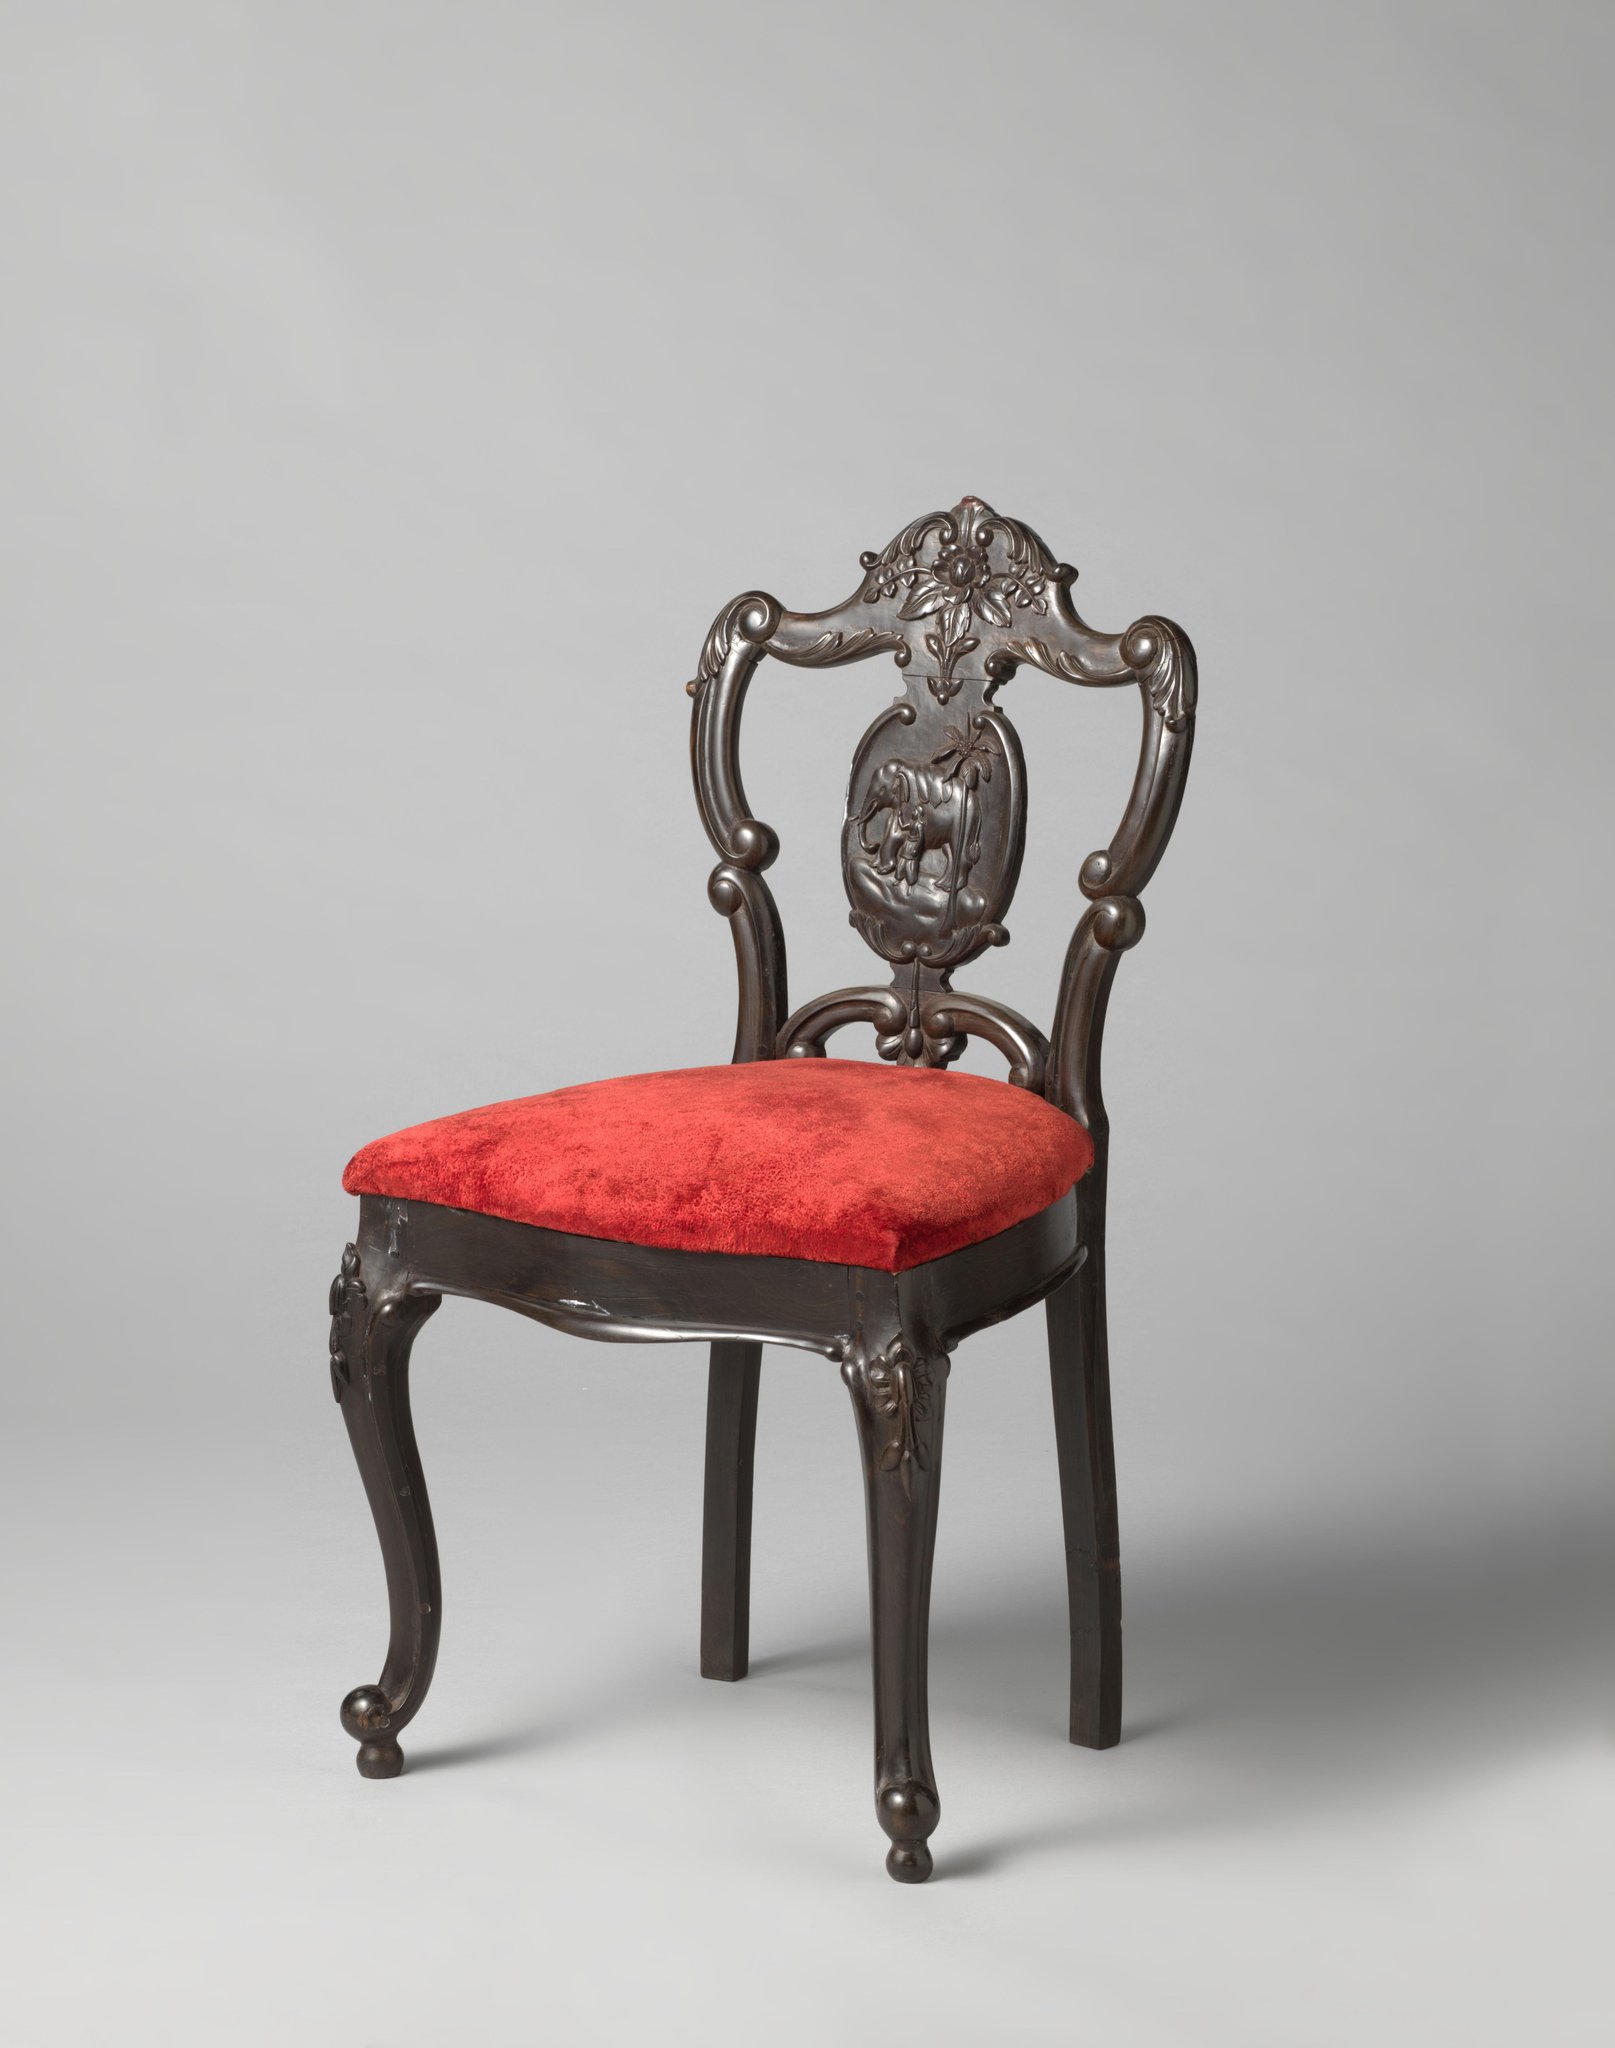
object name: chair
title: Stoel met in rug reliëf met leeuw. Losse zitting bekleed met rood fluweel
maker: Anonymous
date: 1850-1875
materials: wood, velvet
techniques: carved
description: Stoel van ebbenhout waarvan de losse zitting met rood fluweel is bekleed. Medaillon in opengewerkte rug met in laag reliëf voorstelling van een leeuw. Volgens overlevering vervaardigd voor de sultan van Medan.